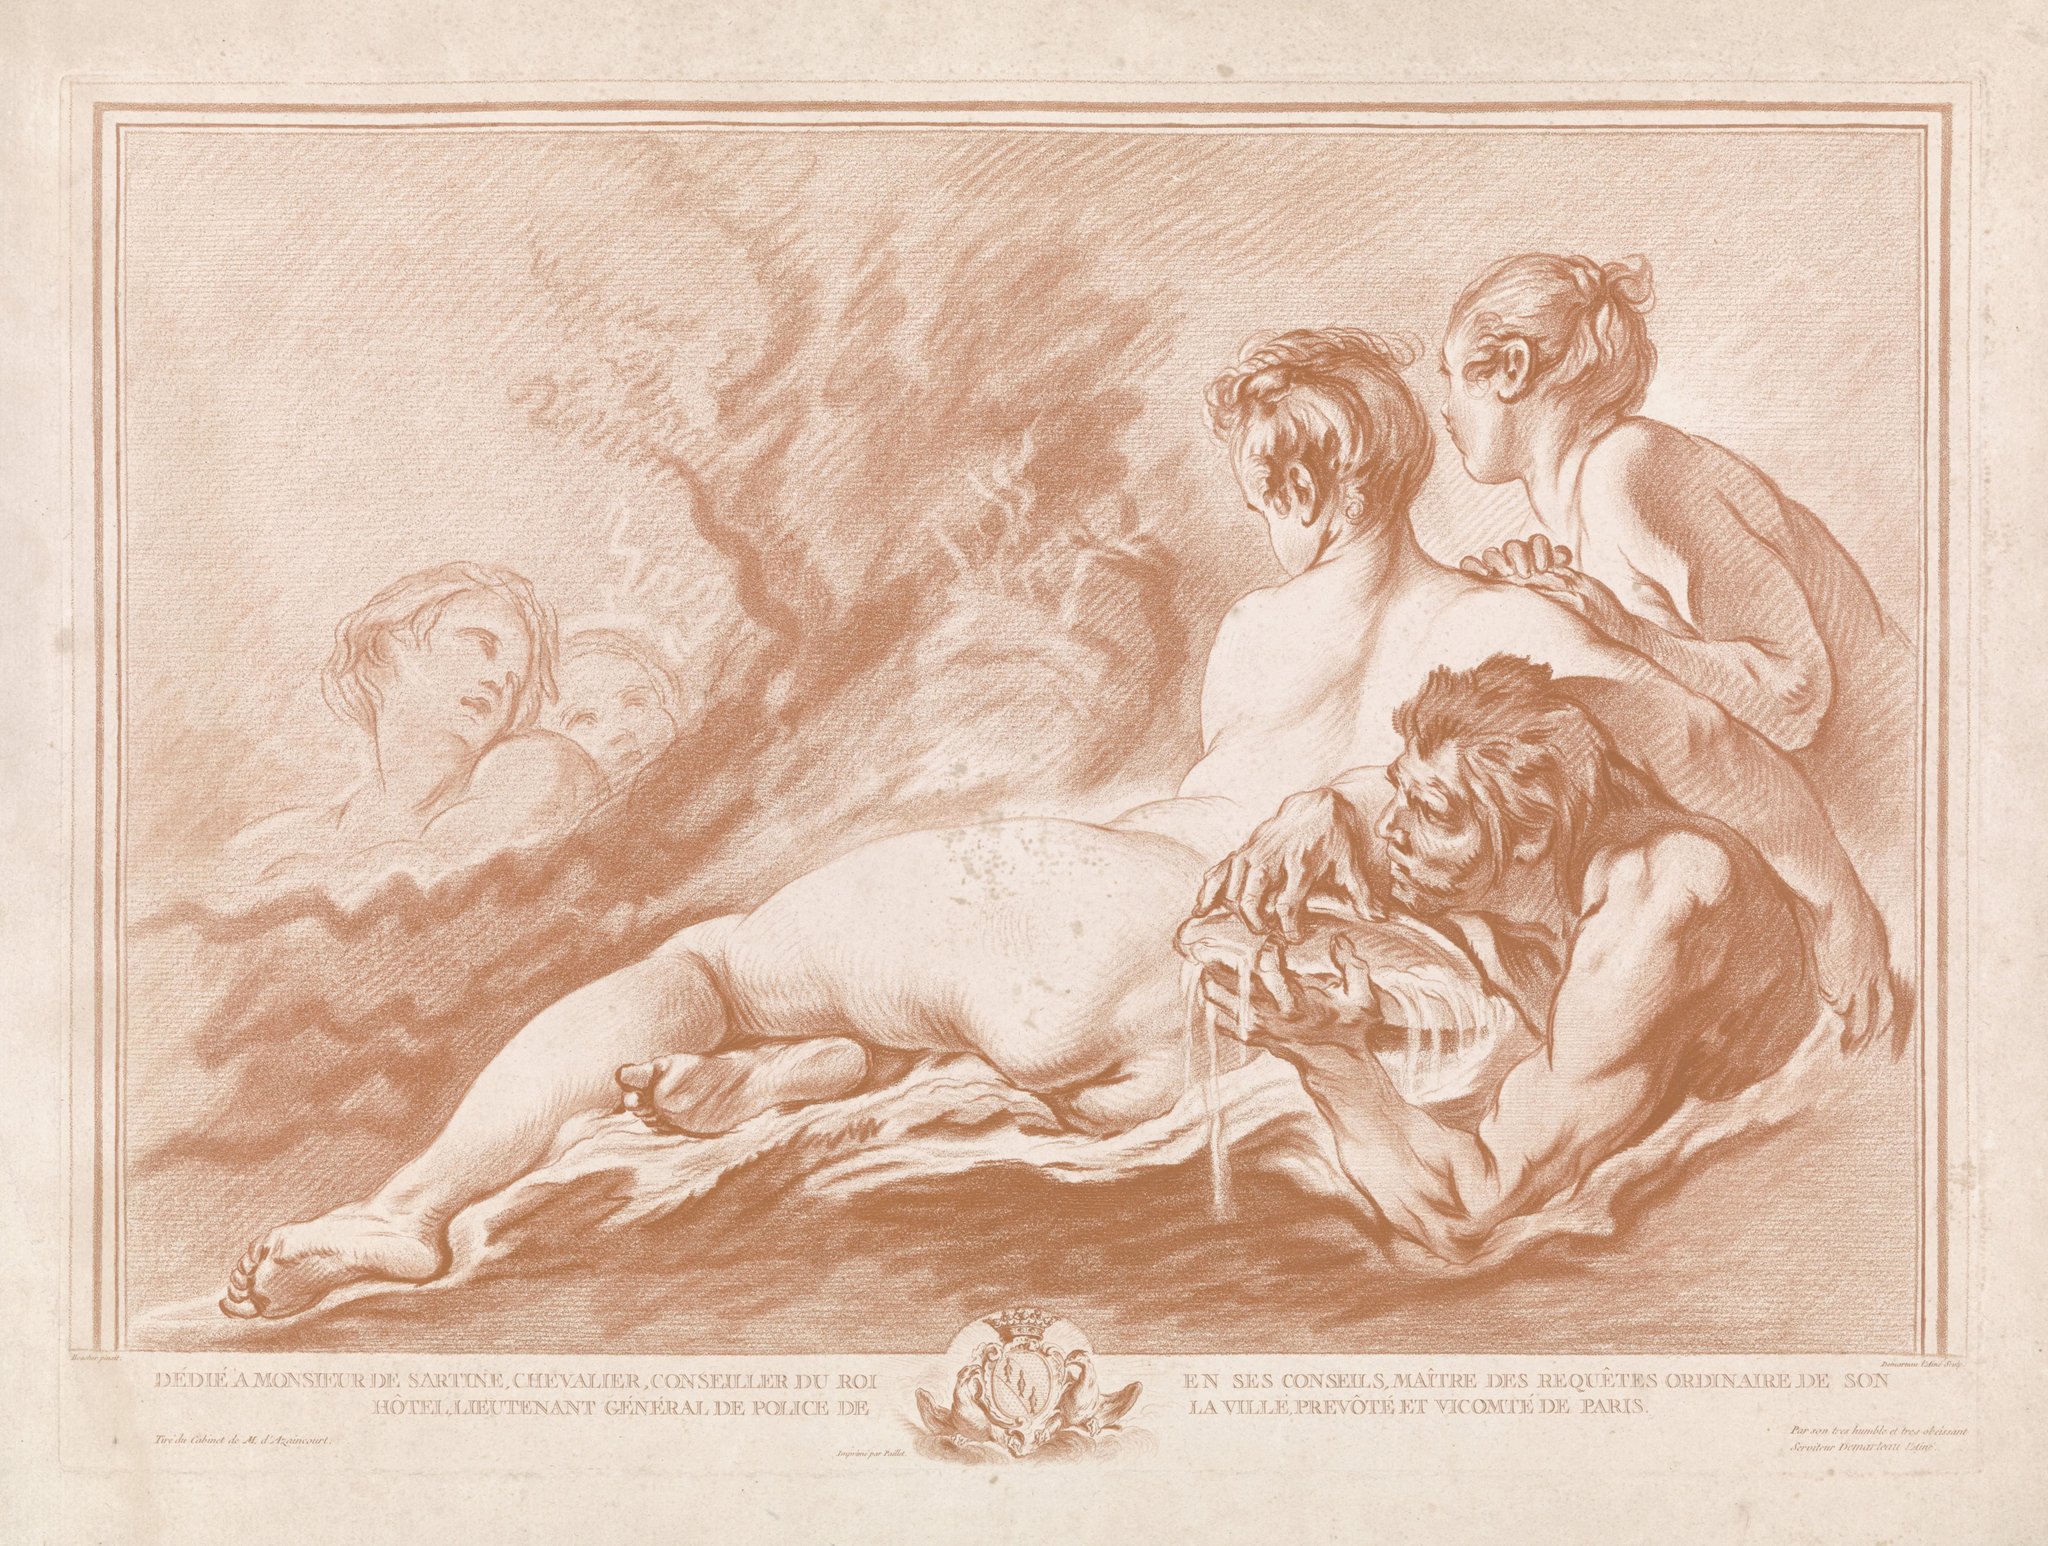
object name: print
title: Allegorische figuren in zee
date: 1732-1776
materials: paper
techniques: printmaking, etching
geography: paris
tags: triton(s), nereids, daughters of nereus; sea-nymphs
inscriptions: collector's mark: Lugt 2760, collector's mark: Lugt 2228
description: Prent naar schilderij in collectie van mevrouw d'Azaincourt, aldus opschrift.